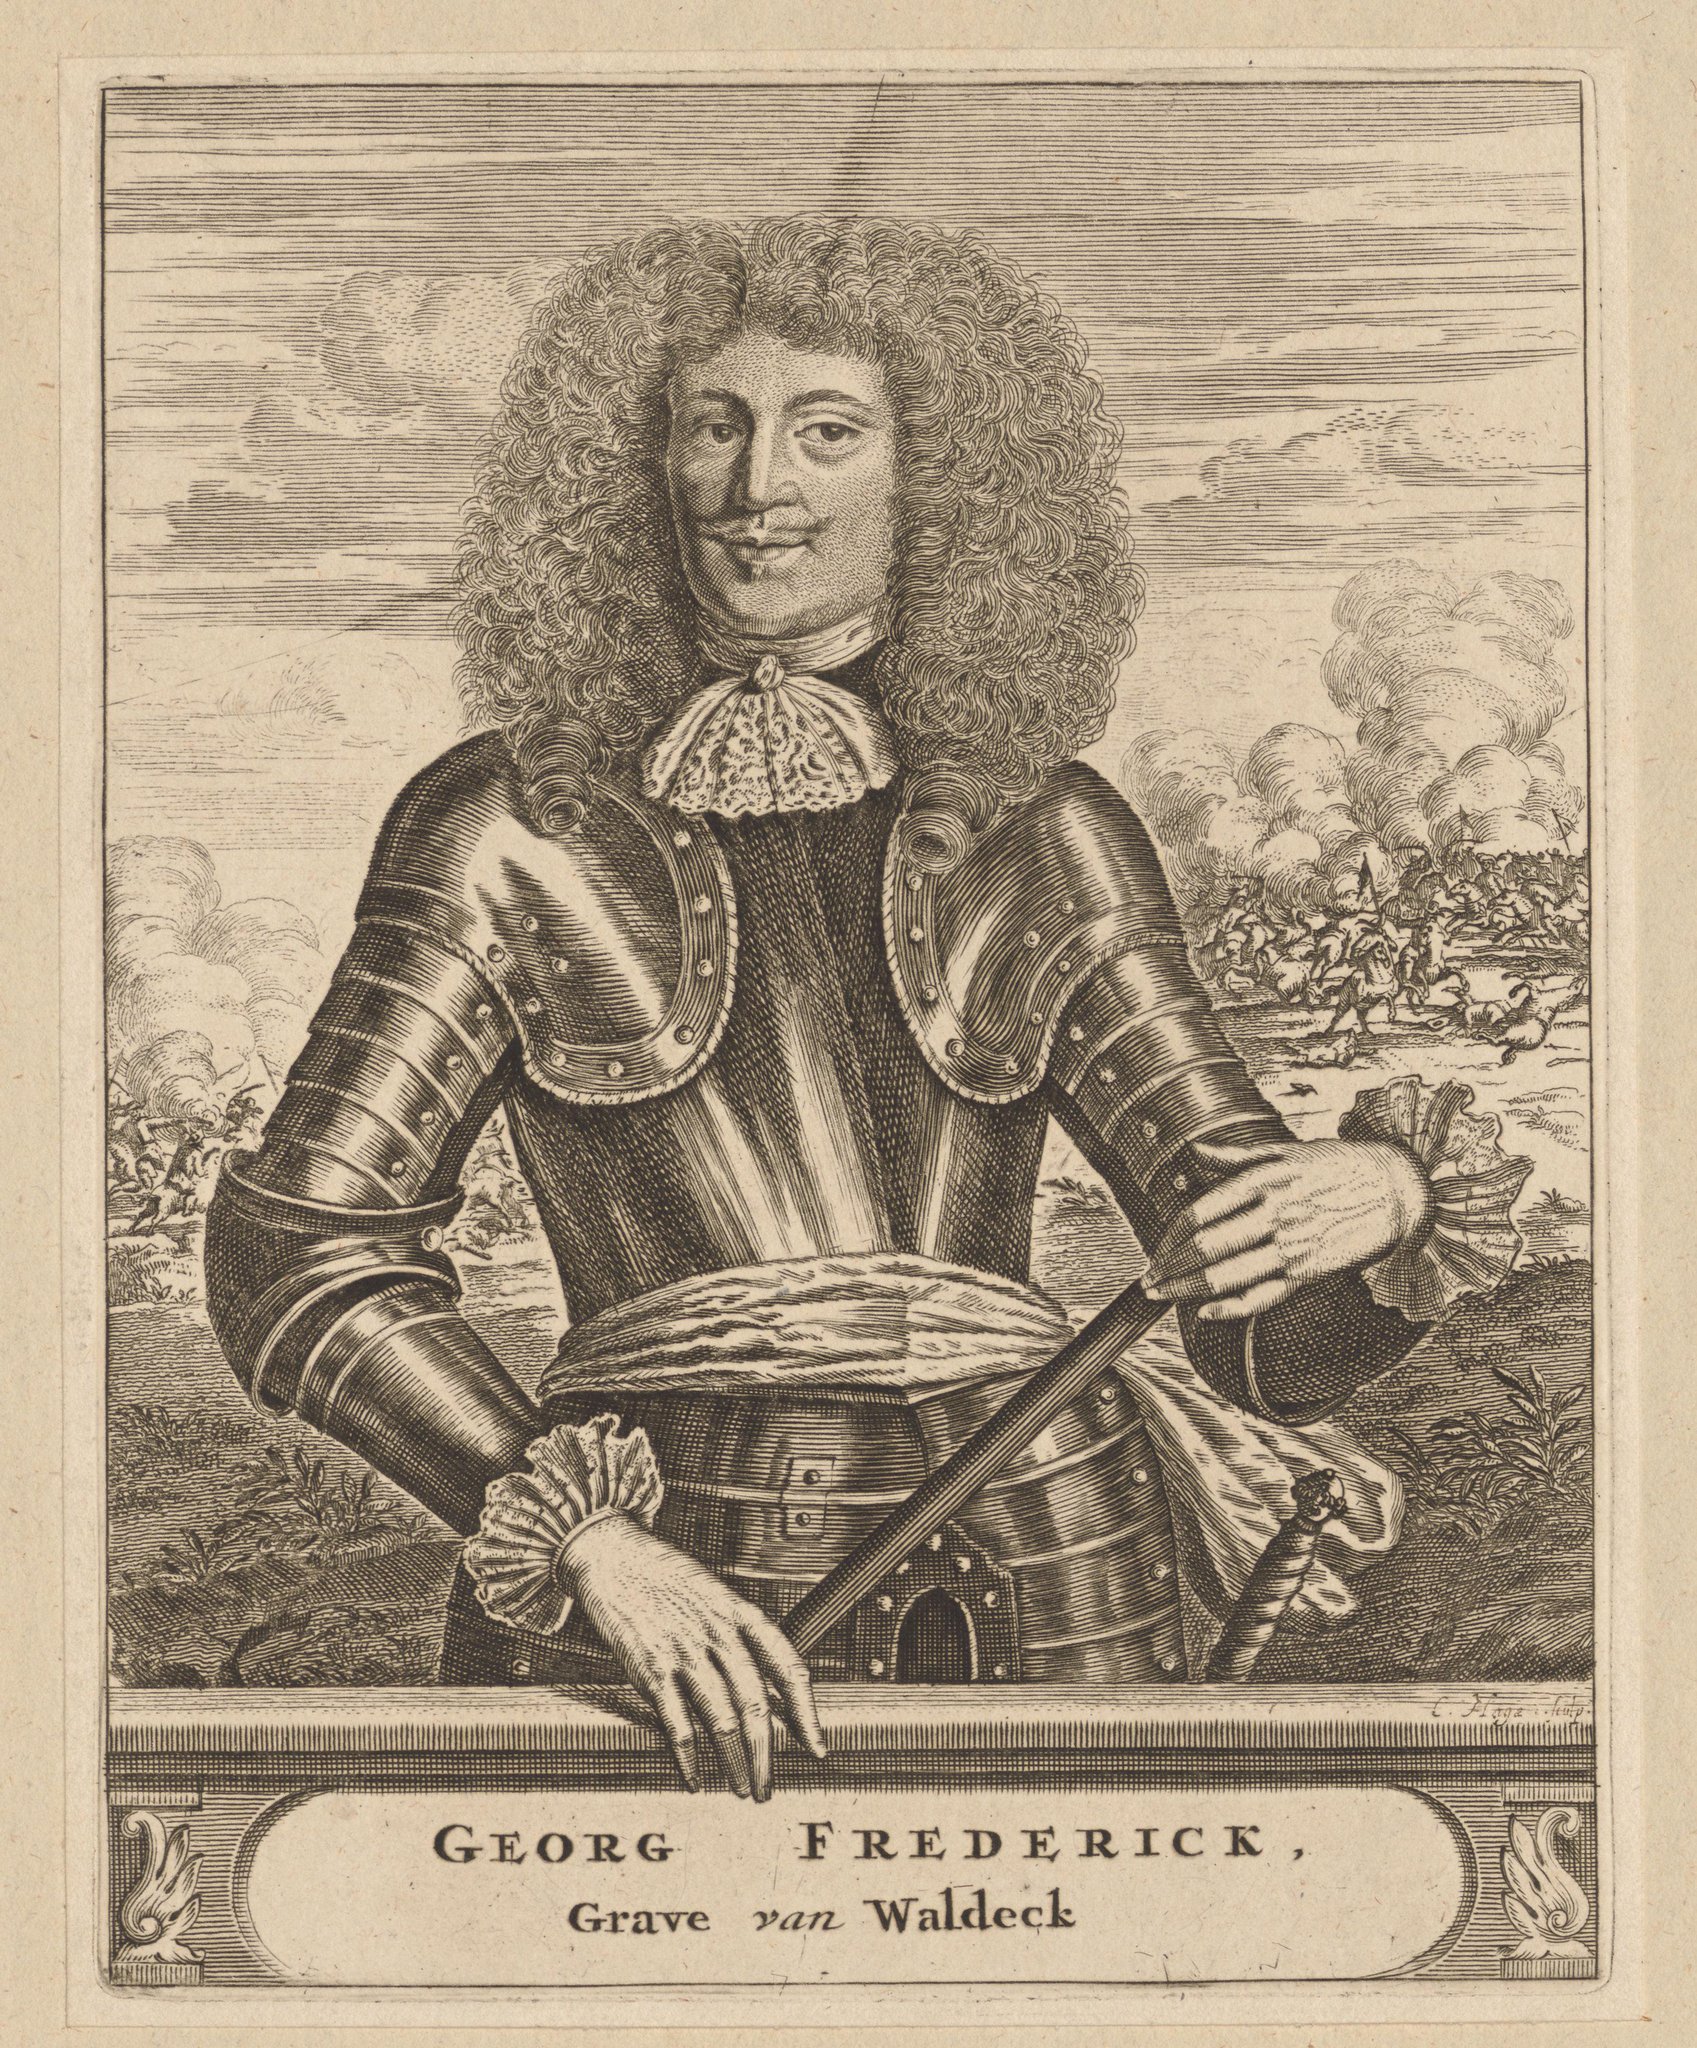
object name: print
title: Portret van Georg Friedrich prins van Waldeck-Eisenberg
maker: christiaan hagen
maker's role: draughtsman, print maker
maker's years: 1635-1707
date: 1675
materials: paper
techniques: engraving, etching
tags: commander-in-chief, general, marshal, armour, prince, historical persons, battle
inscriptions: inscription: ‘C. Hage Sculp.’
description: Prent waarschijnlijk uit: Bos, Lambert van den. Schau-platz des Krieges: Aufgerichtet in den Vereinigten Niederlanden (...). Amsterdam: Jacob van Meurs en Johannes van Someren, 1675.